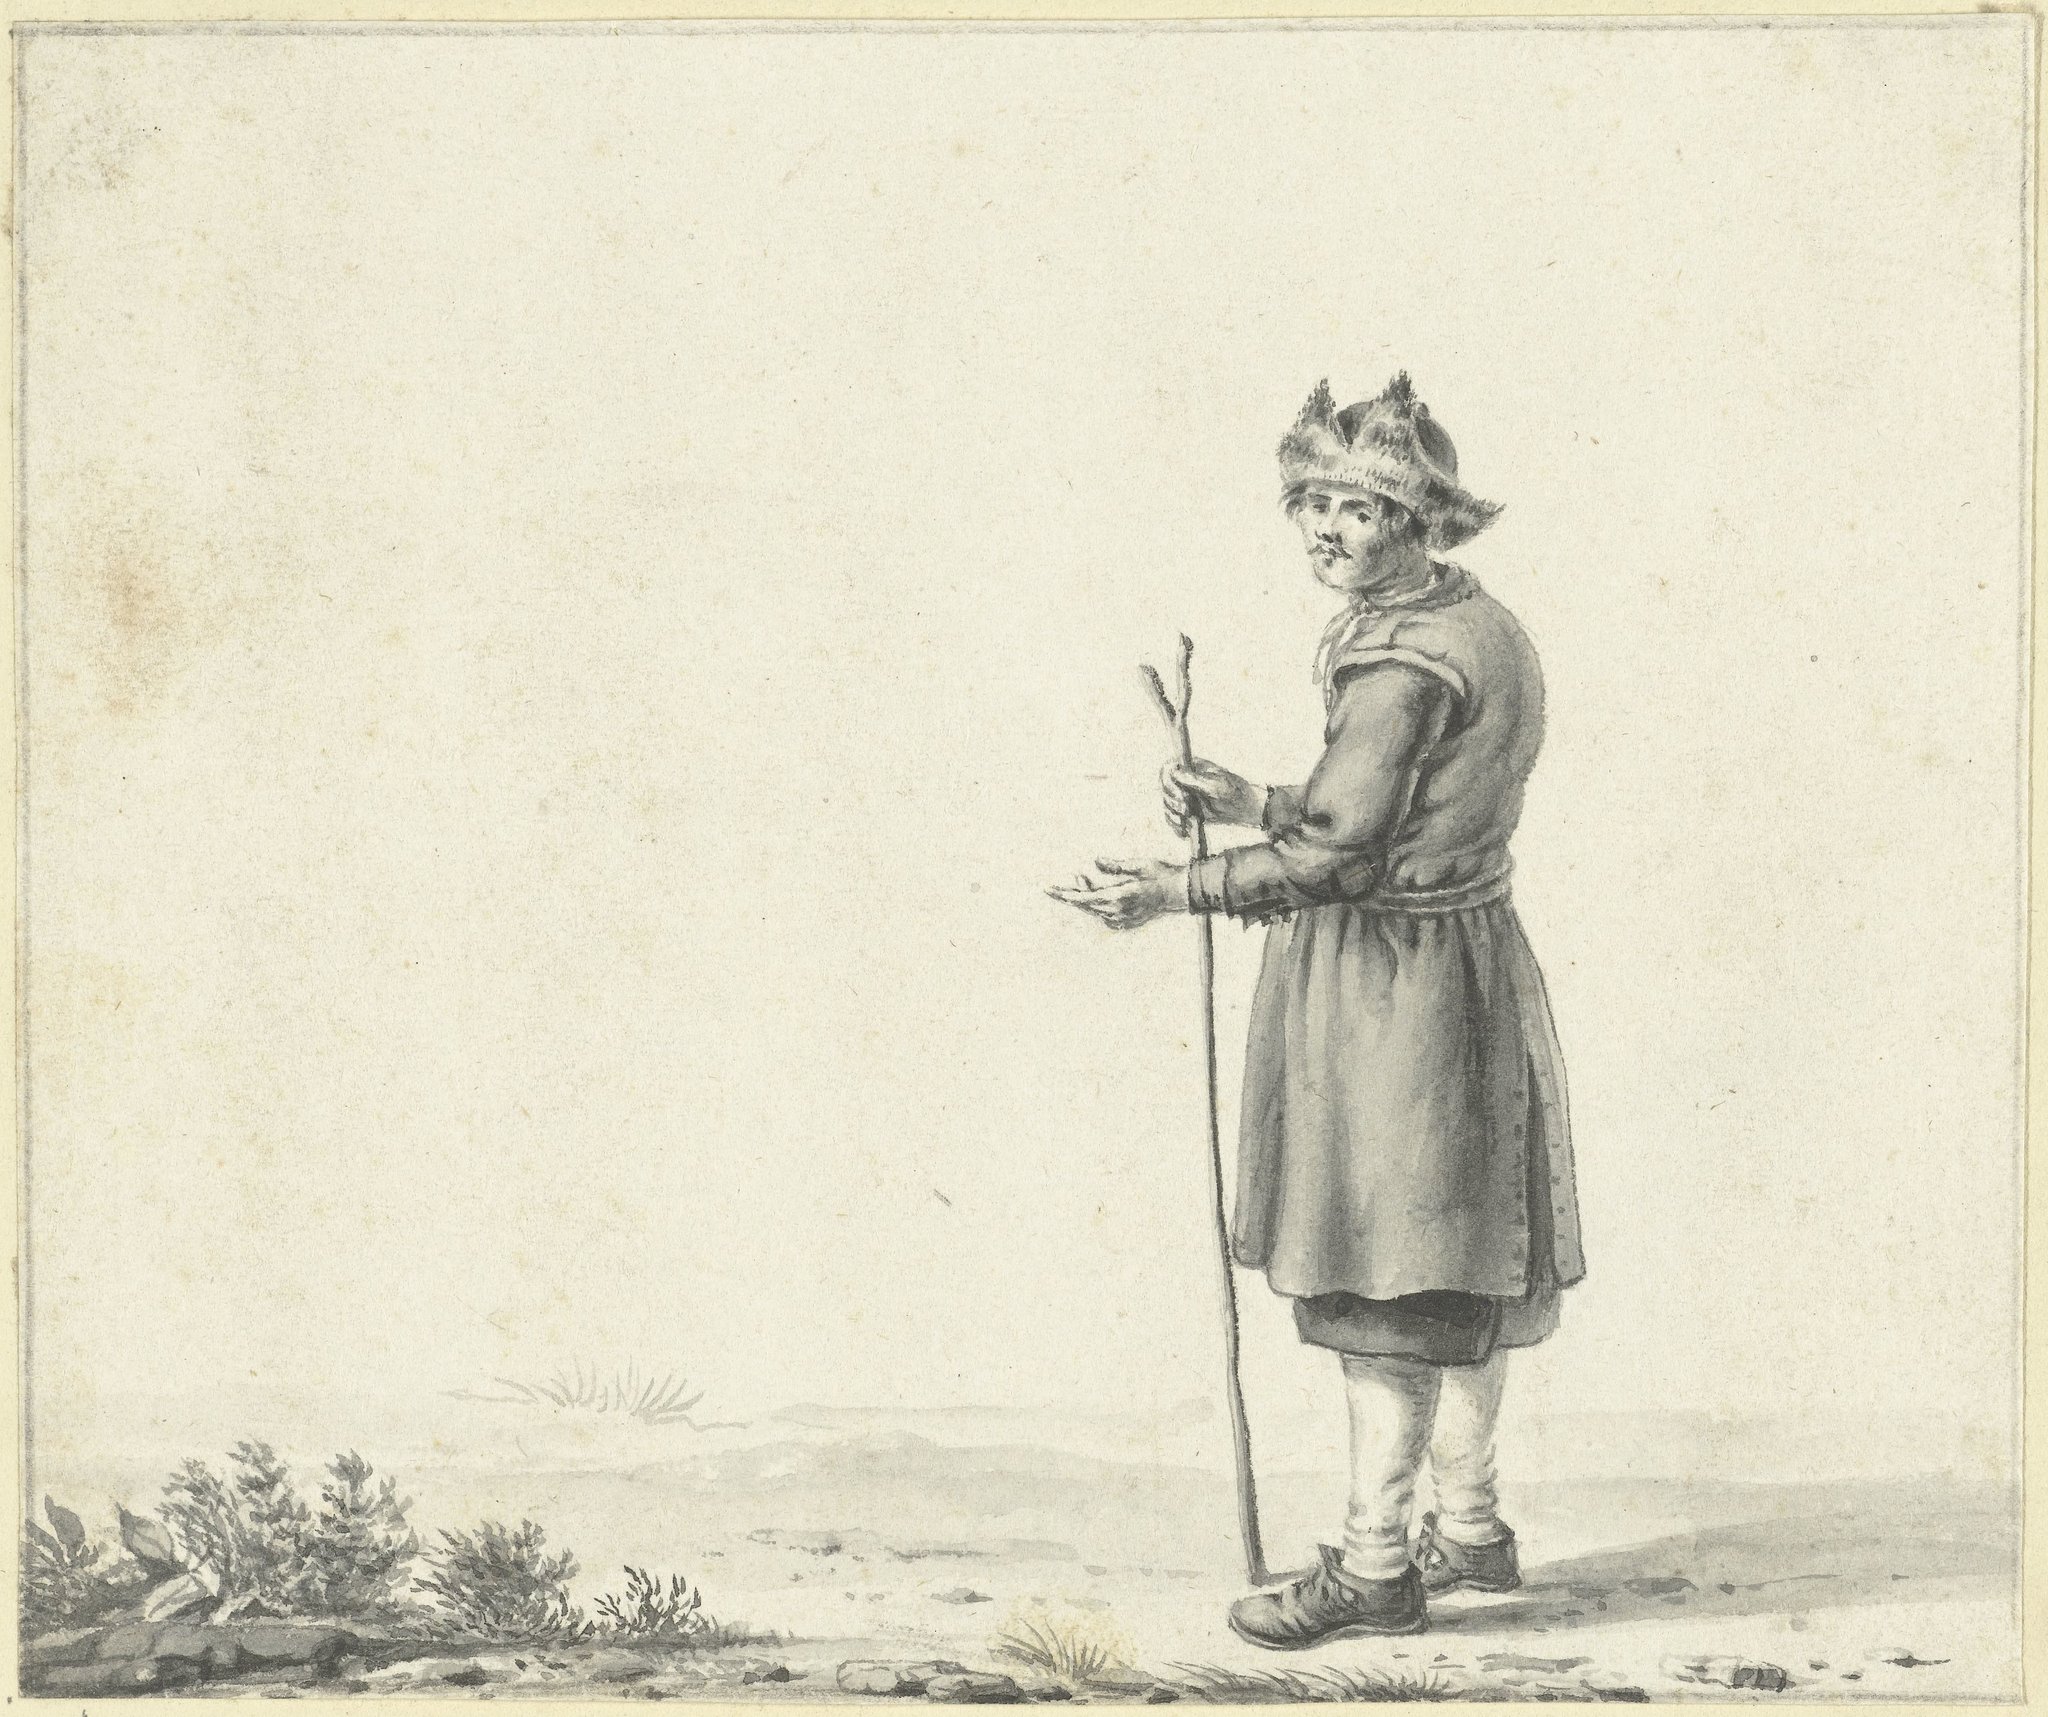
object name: drawing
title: Staande man met bontmuts en stok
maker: hendrik rietschoof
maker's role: draughtsman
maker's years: 1678-1746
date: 1697-1746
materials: ink, paper, pencil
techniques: brush, pen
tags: head-gear (with name)